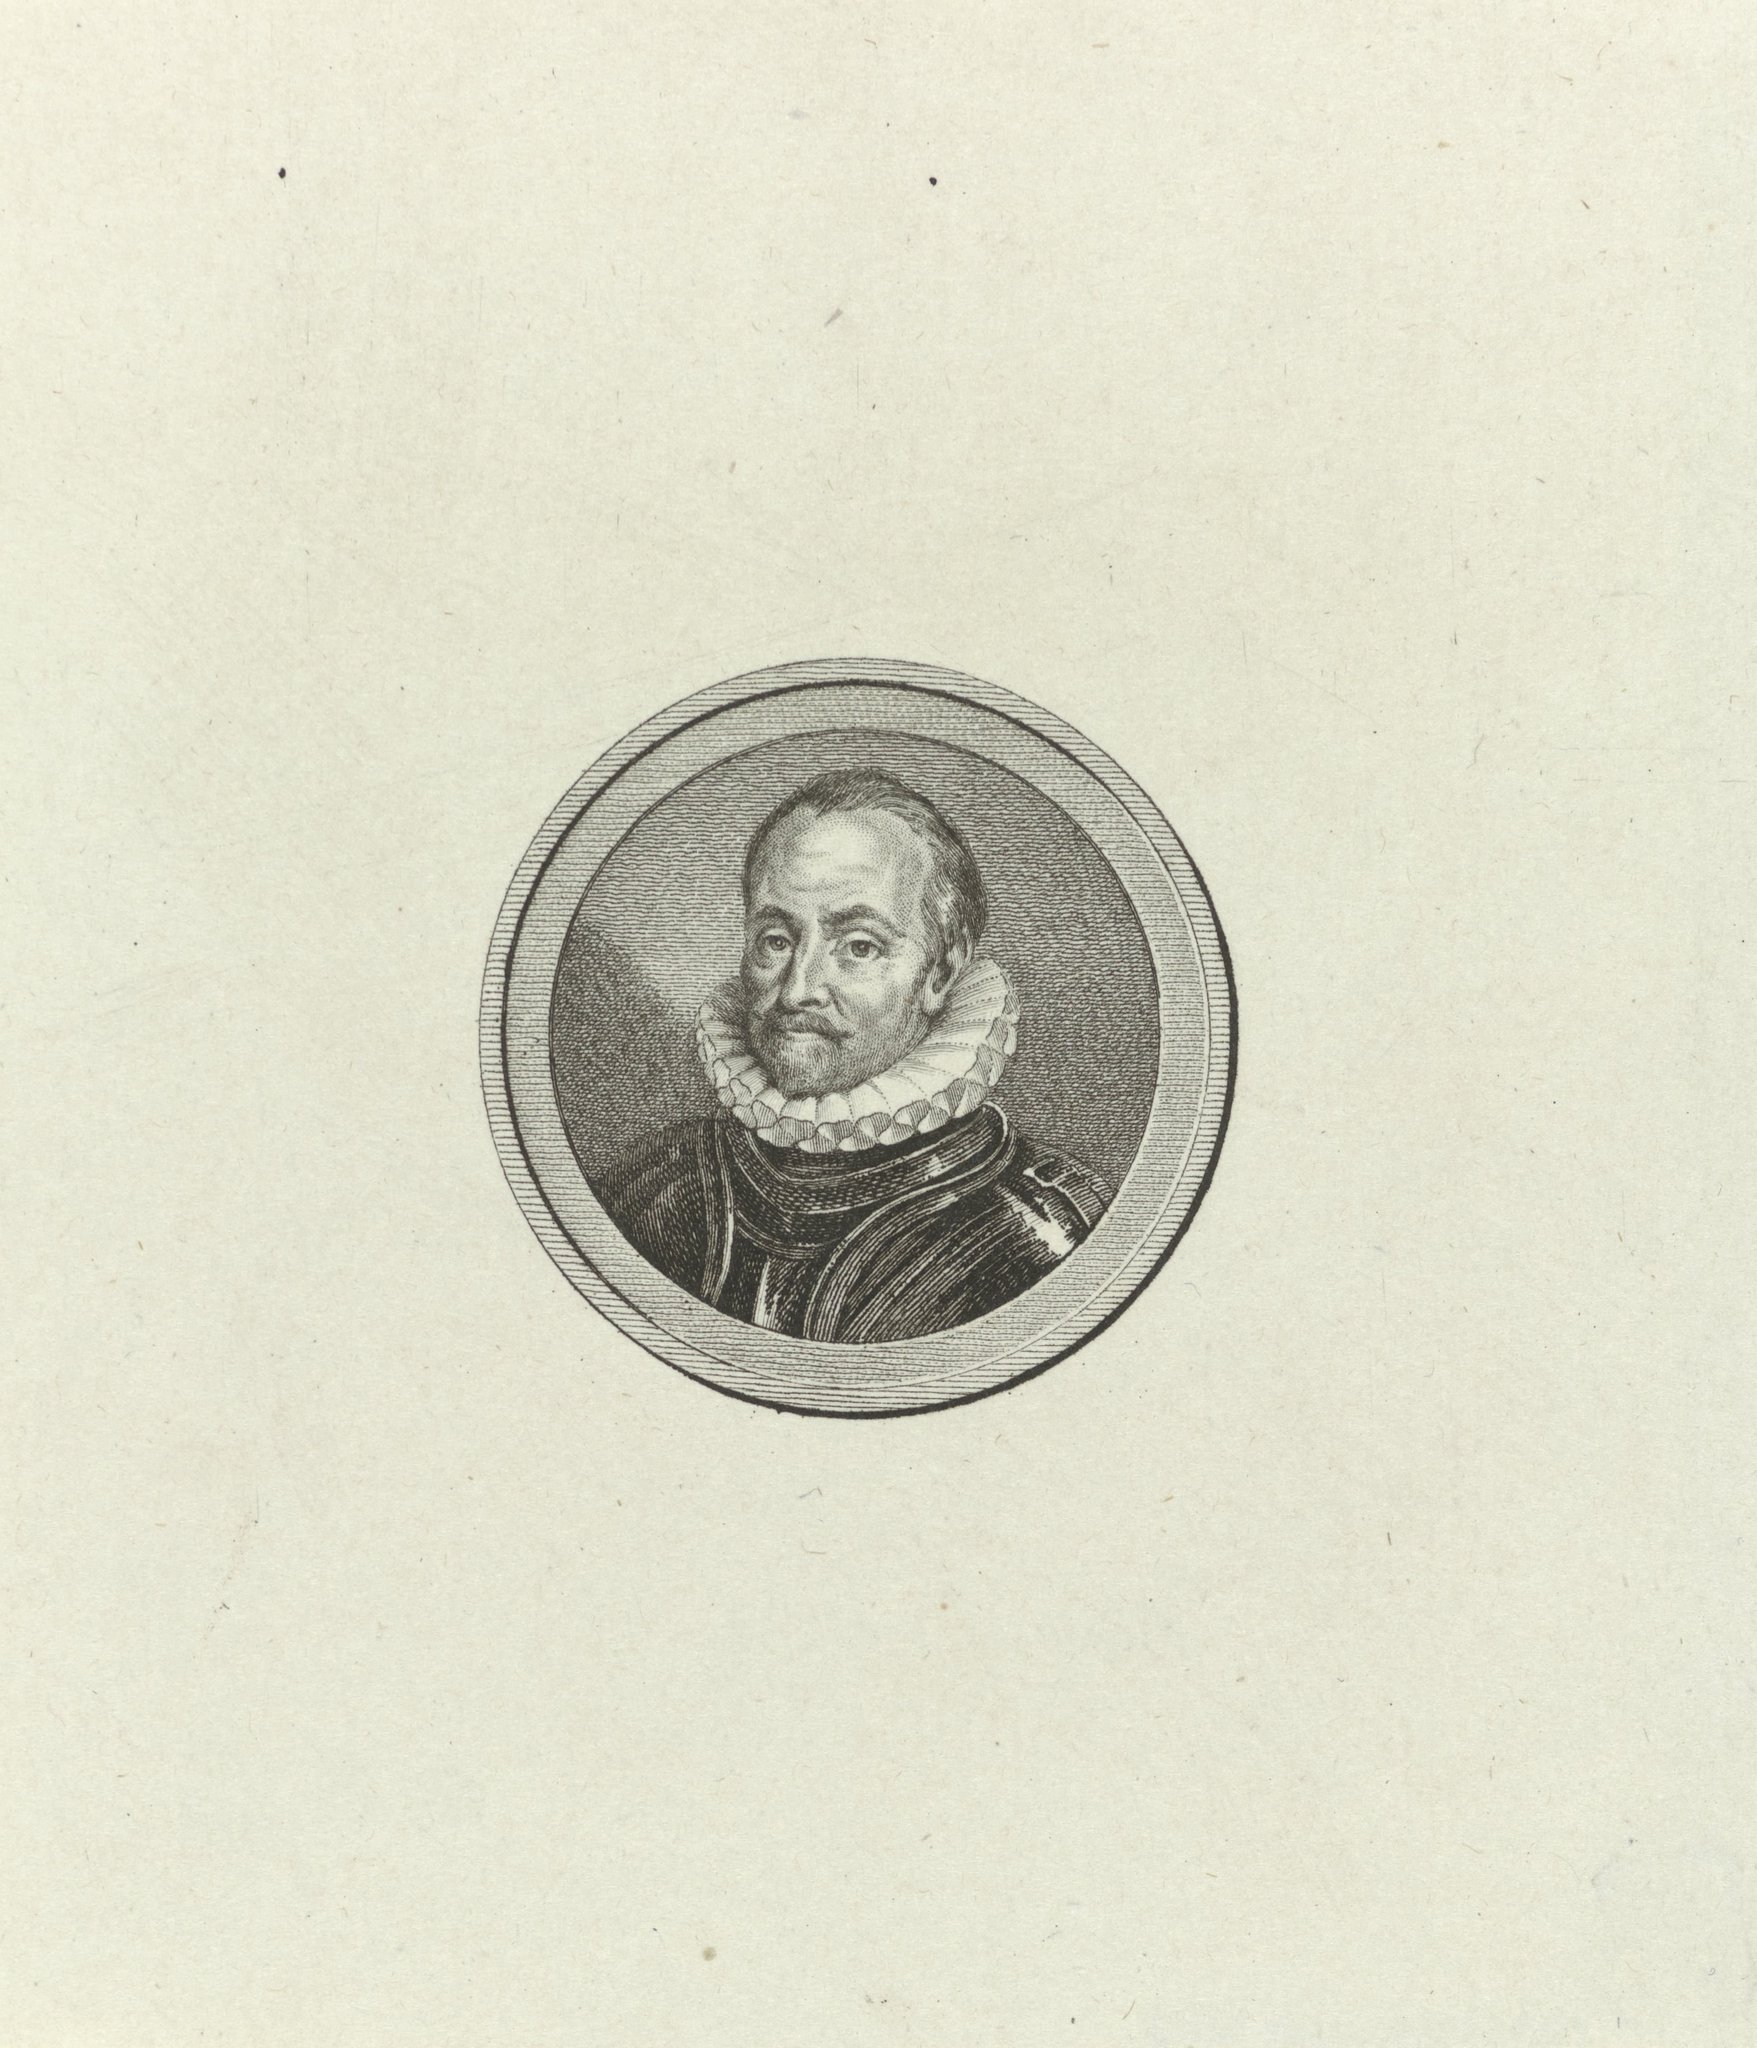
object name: print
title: Portret van Willem I, prins van Oranje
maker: reinier vinkeles (i)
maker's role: draughtsman, print maker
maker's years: 1741-1816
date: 1762-1816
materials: paper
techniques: engraving, etching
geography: amsterdam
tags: delft, william i (prince of orange)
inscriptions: collector's mark: Lugt 963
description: De hier vermelde titel verwijst naar de hoogst verkregen titel van de geportretteerde, niet per se naar de titel die de geportretteerde op deze voorstelling draagt.